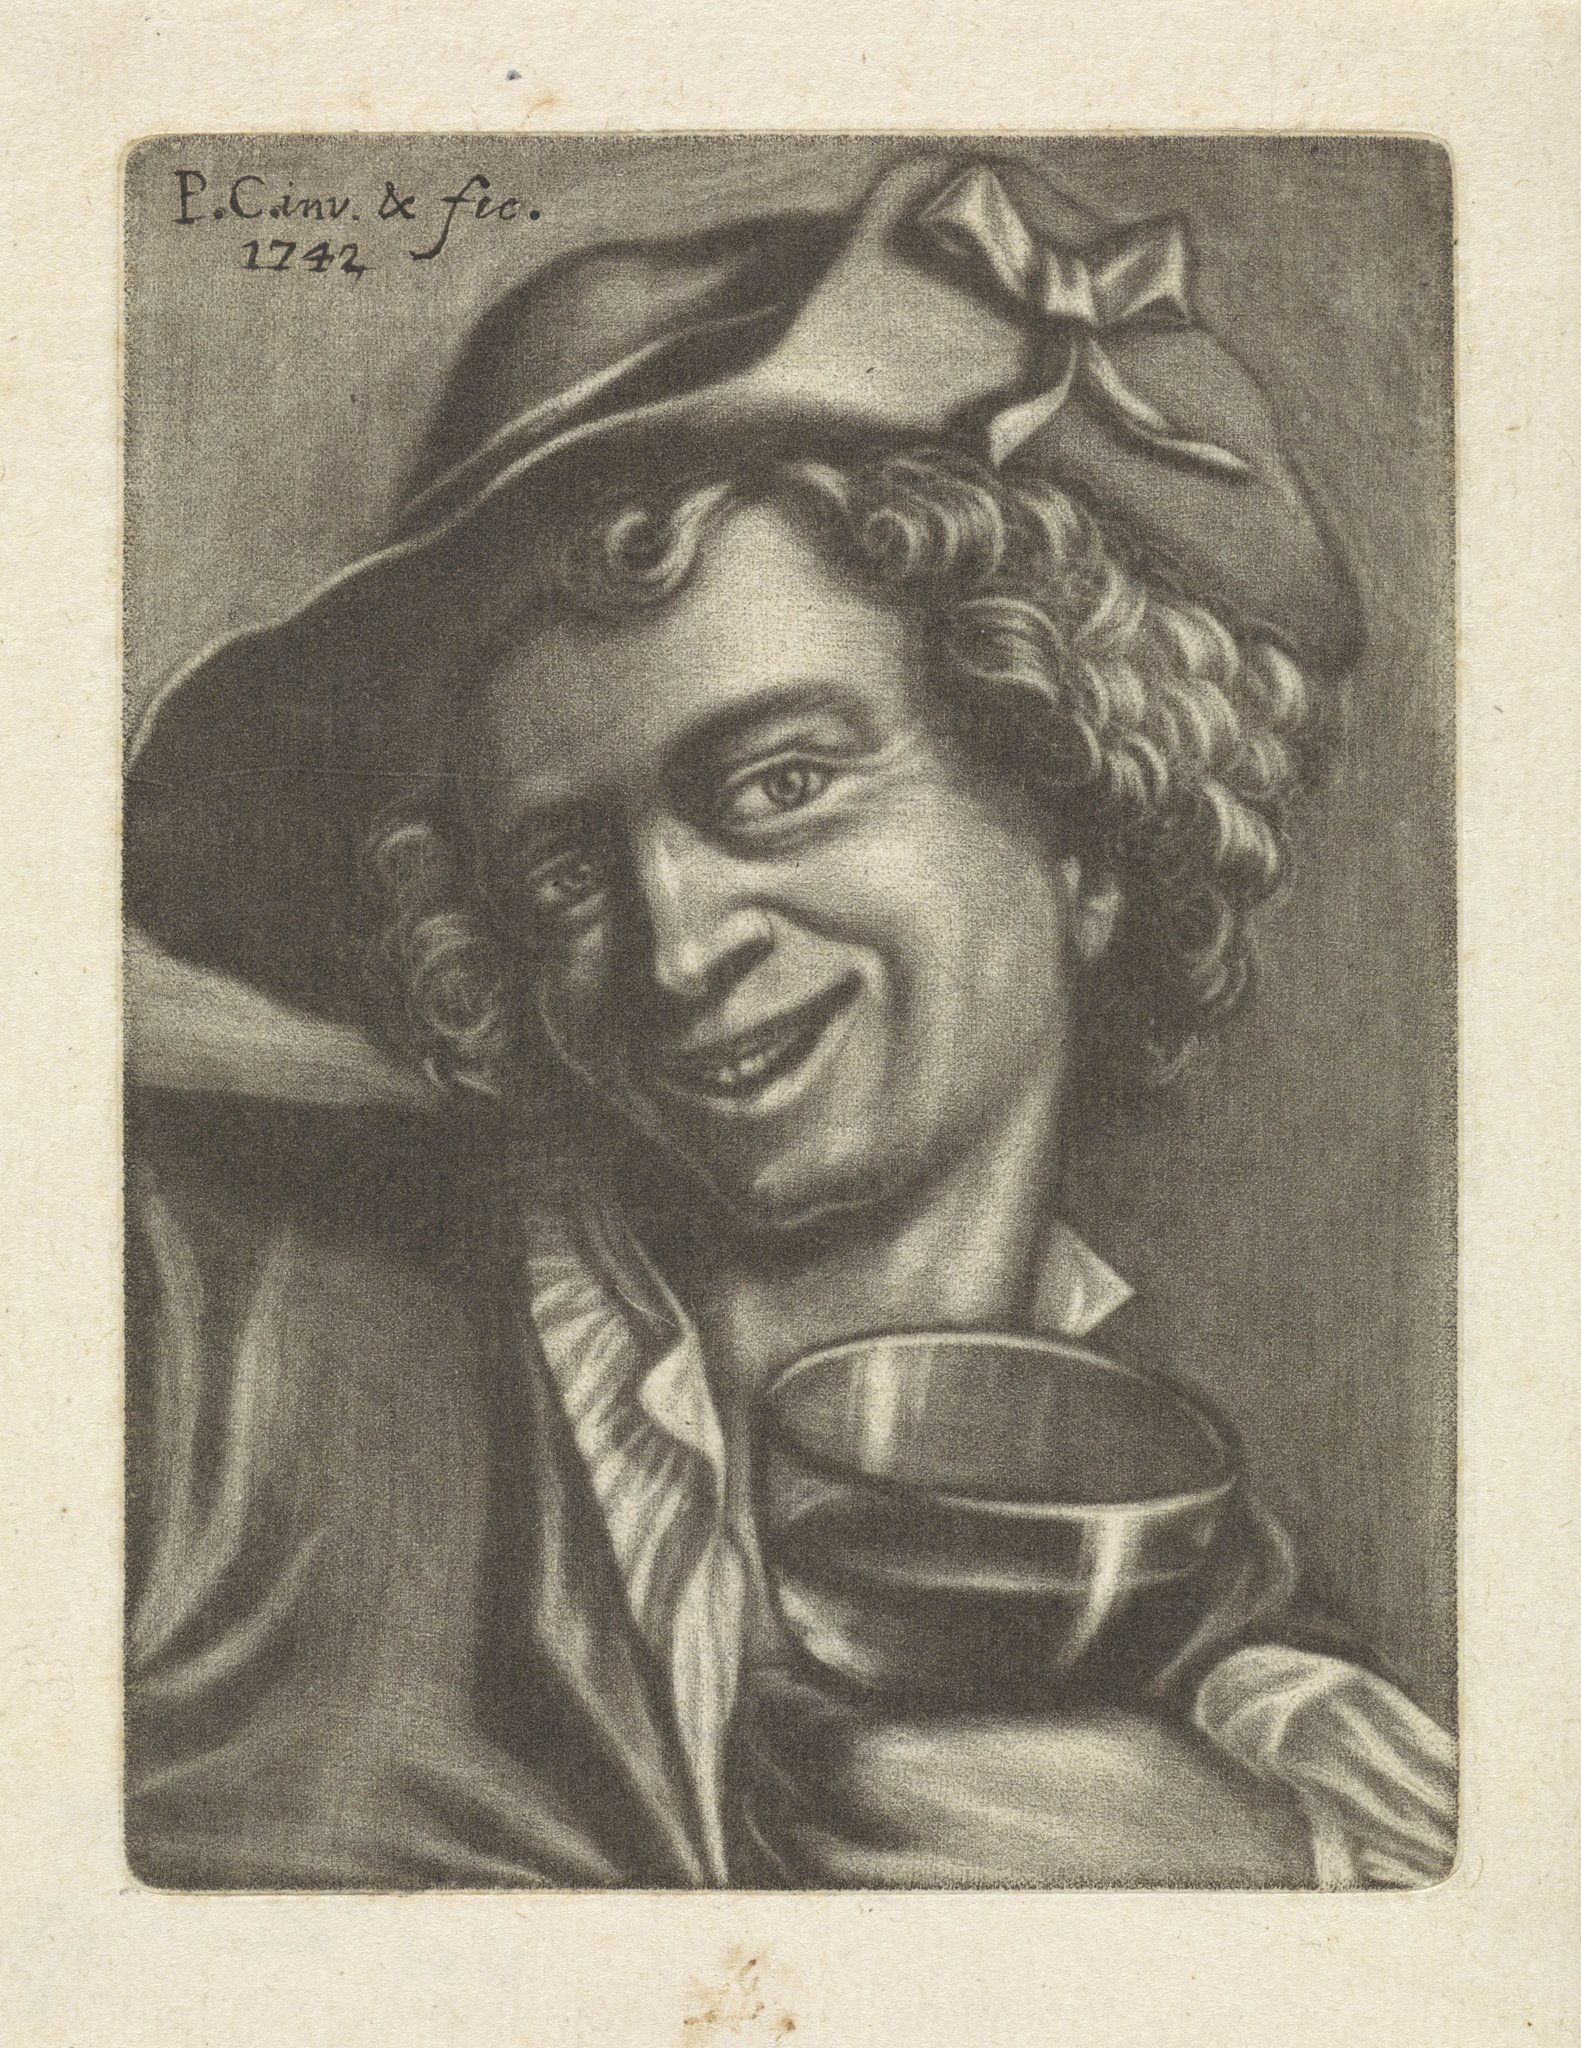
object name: print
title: Lachende jongen met een glas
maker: petrus camper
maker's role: draughtsman, print maker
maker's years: 1722-1789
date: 1742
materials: paper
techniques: engraving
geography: london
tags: laughing, glass, rummer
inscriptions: collector's mark: Lugt 2228